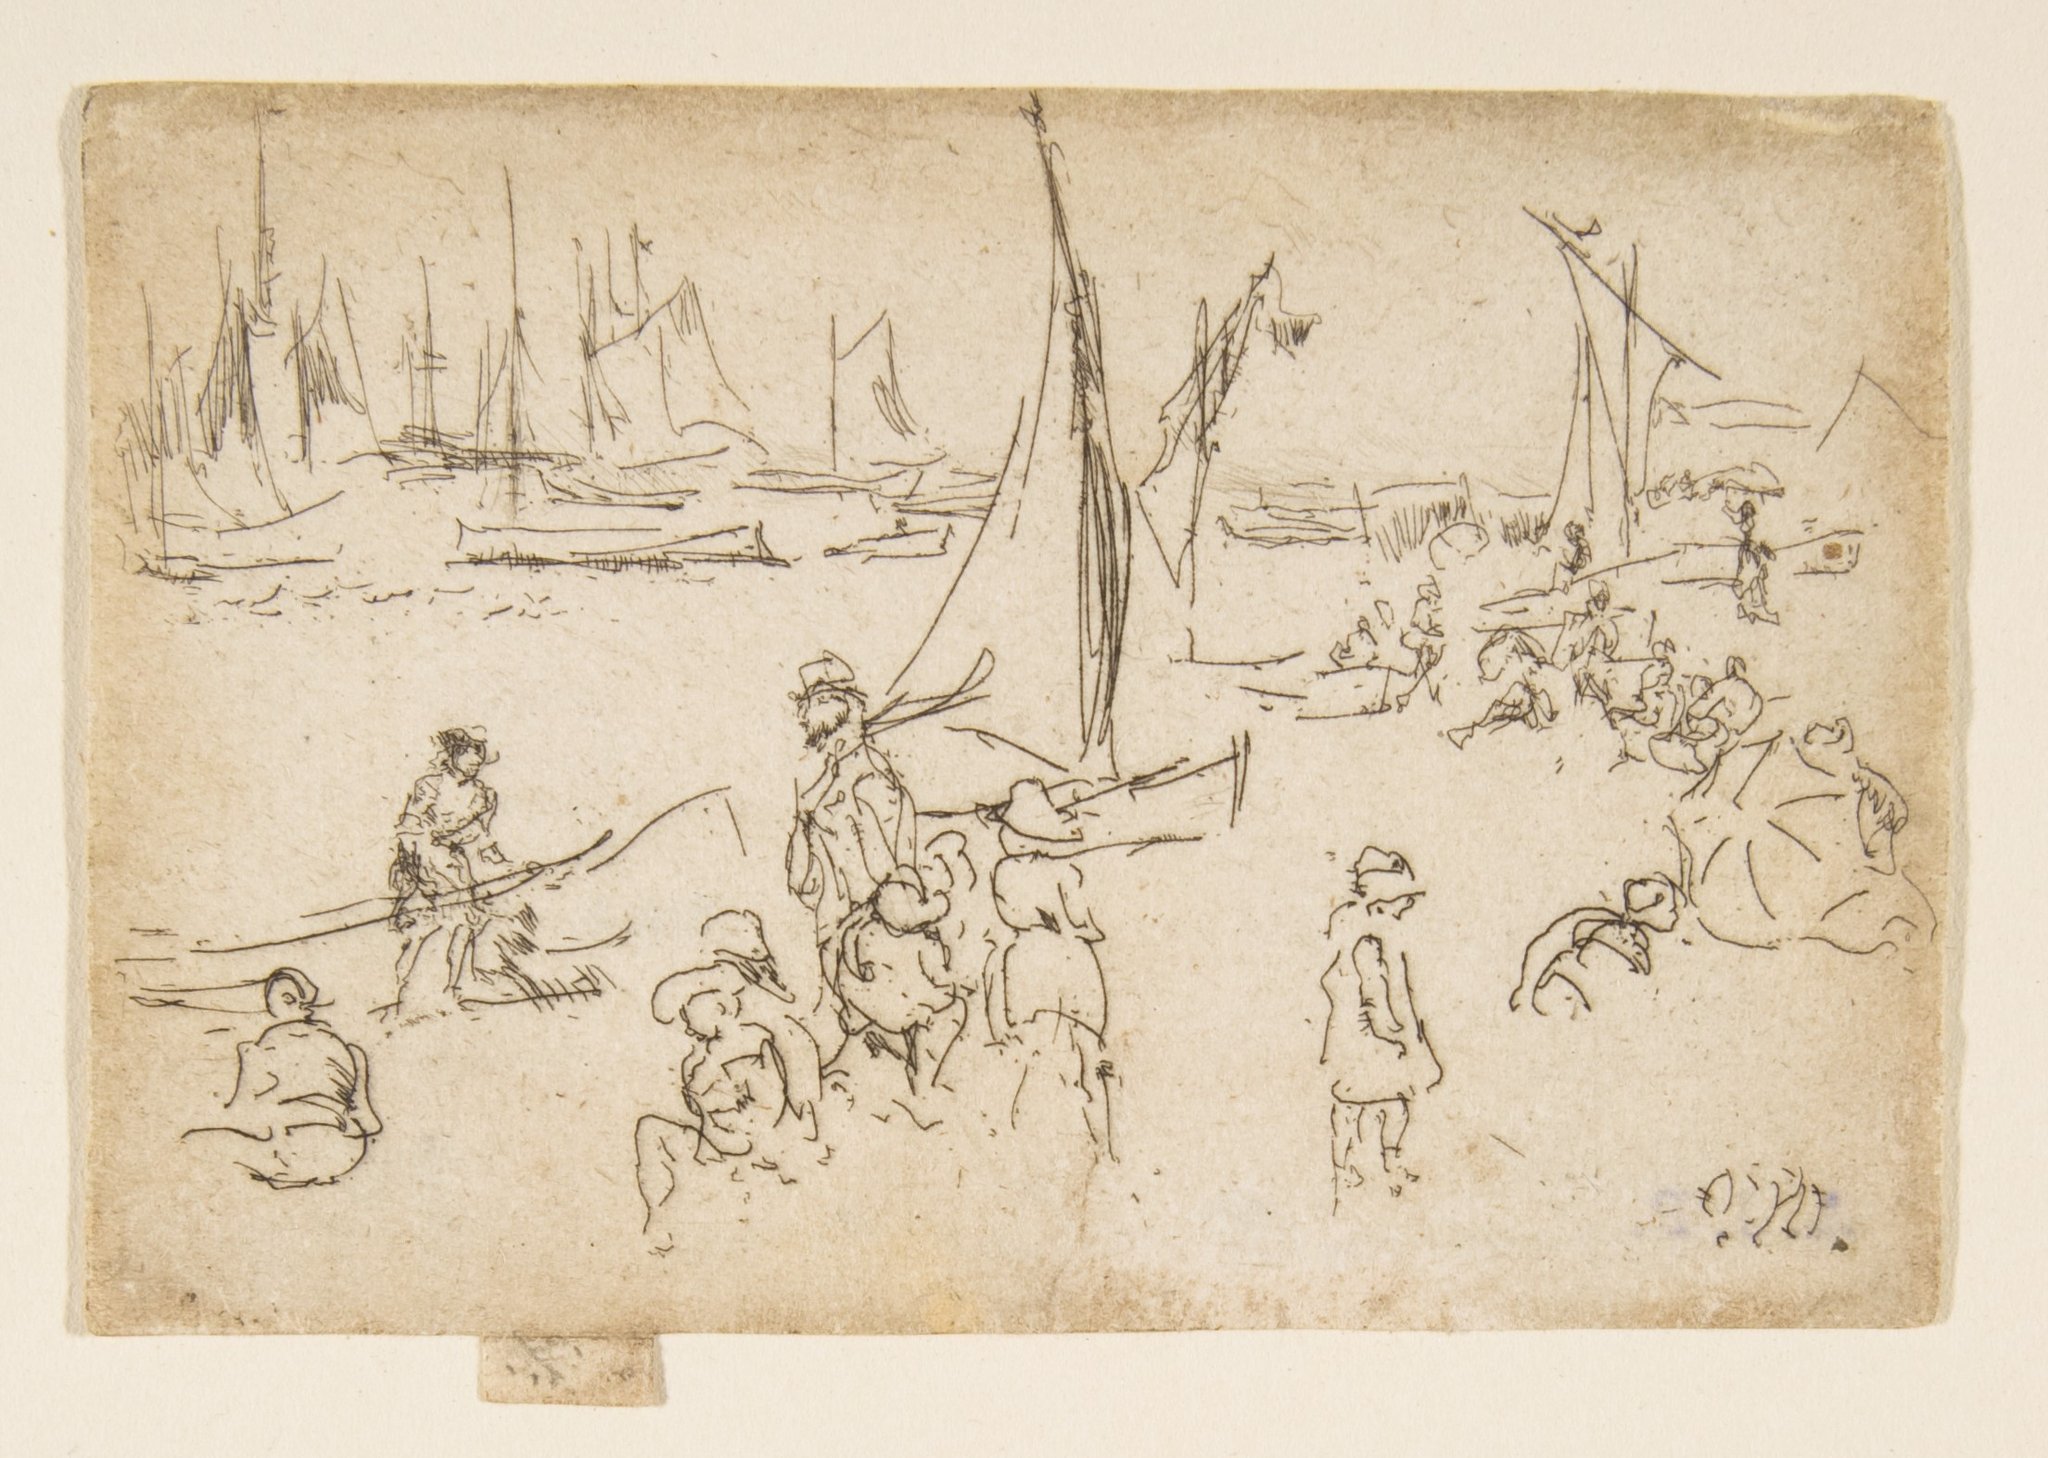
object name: print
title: Portsmouth Children (Children, Portsmouth)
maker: james mcneill whistler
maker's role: artist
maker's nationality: american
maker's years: 1834-1903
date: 1887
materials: ink, paper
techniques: etching, printing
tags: human figures,boats